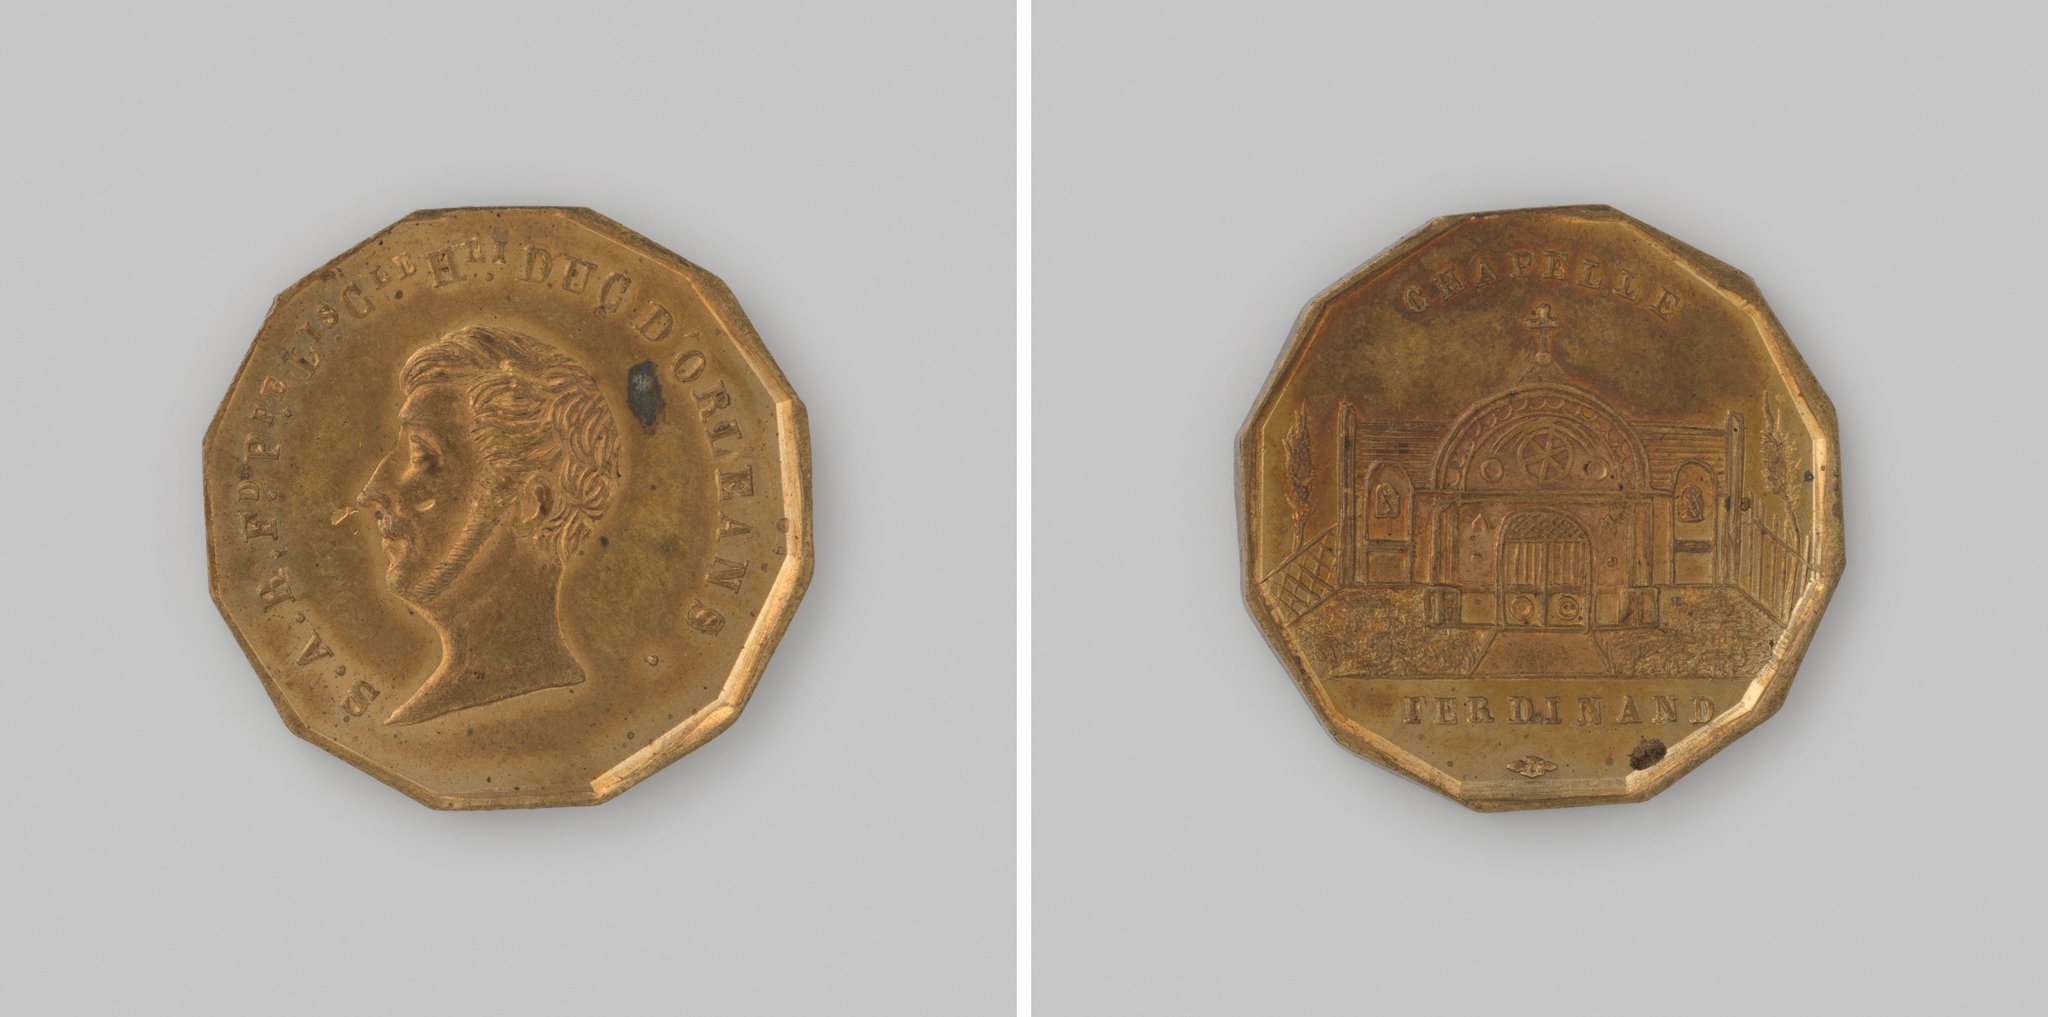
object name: history medal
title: Oprichting van de Kapel St Ferdinand ter ere van de hertog van Orléans 1843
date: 1843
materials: brass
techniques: striking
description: Twaalfhoekige messing penning, op de voorzijde het portret van de hertog van Orléans naar links met omschrift, op de keerzijde het aanzicht van een kapel met omschrift en afsnedetekst.